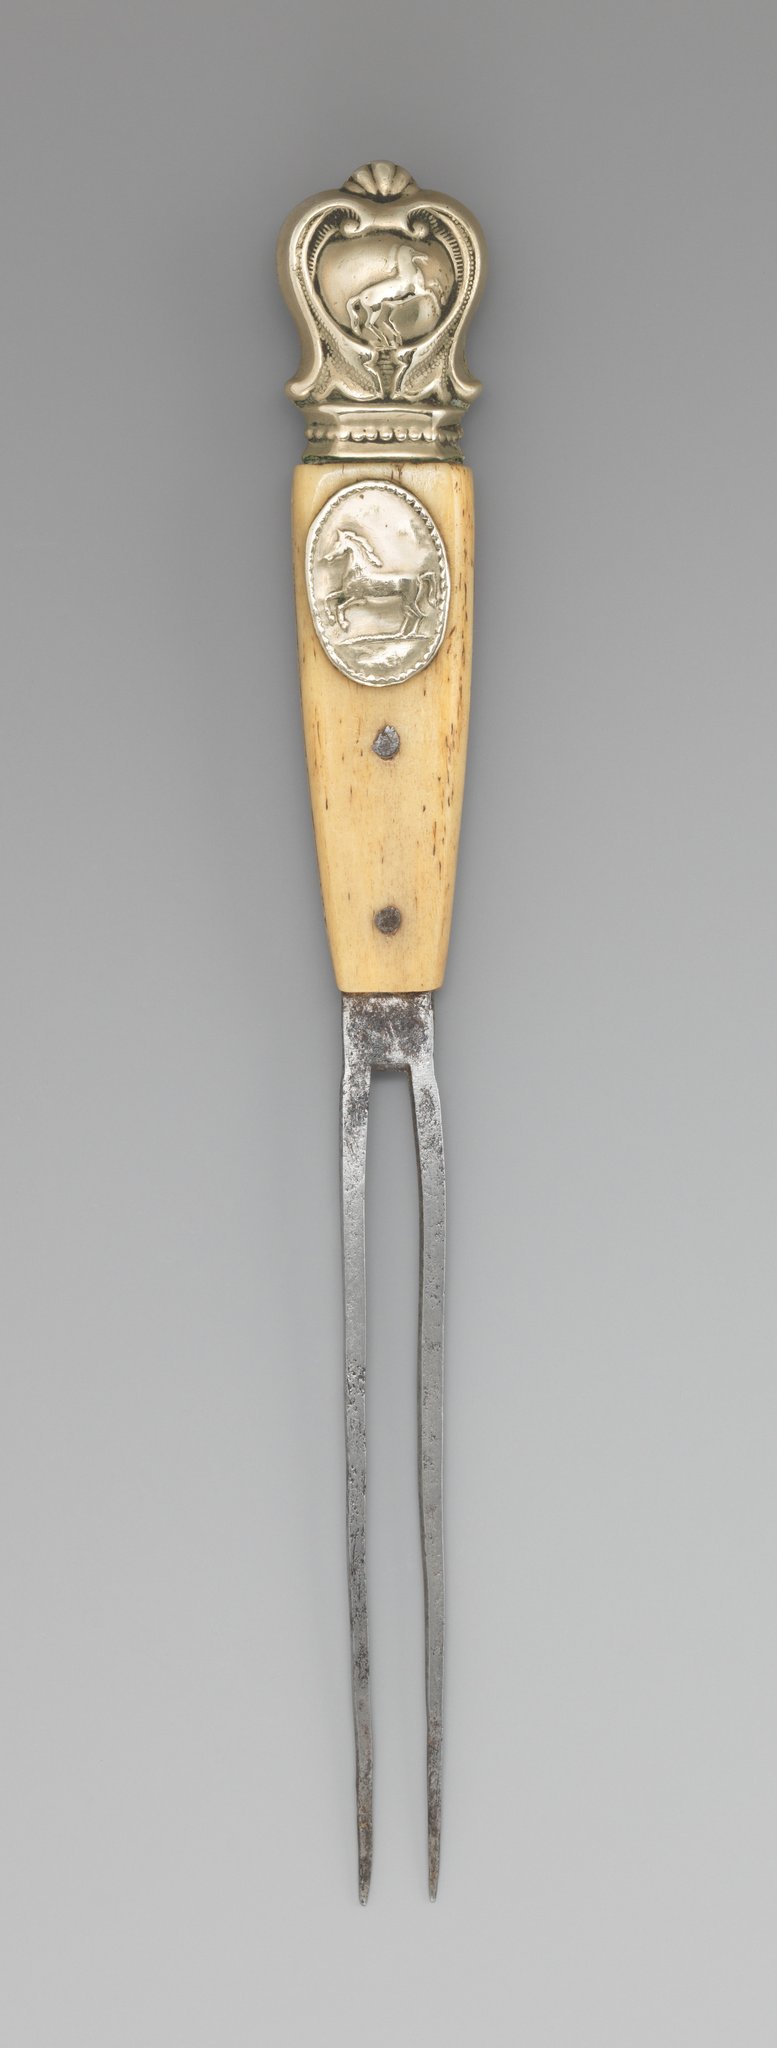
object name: table fork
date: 1751-1800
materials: bone, brass, steel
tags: horses